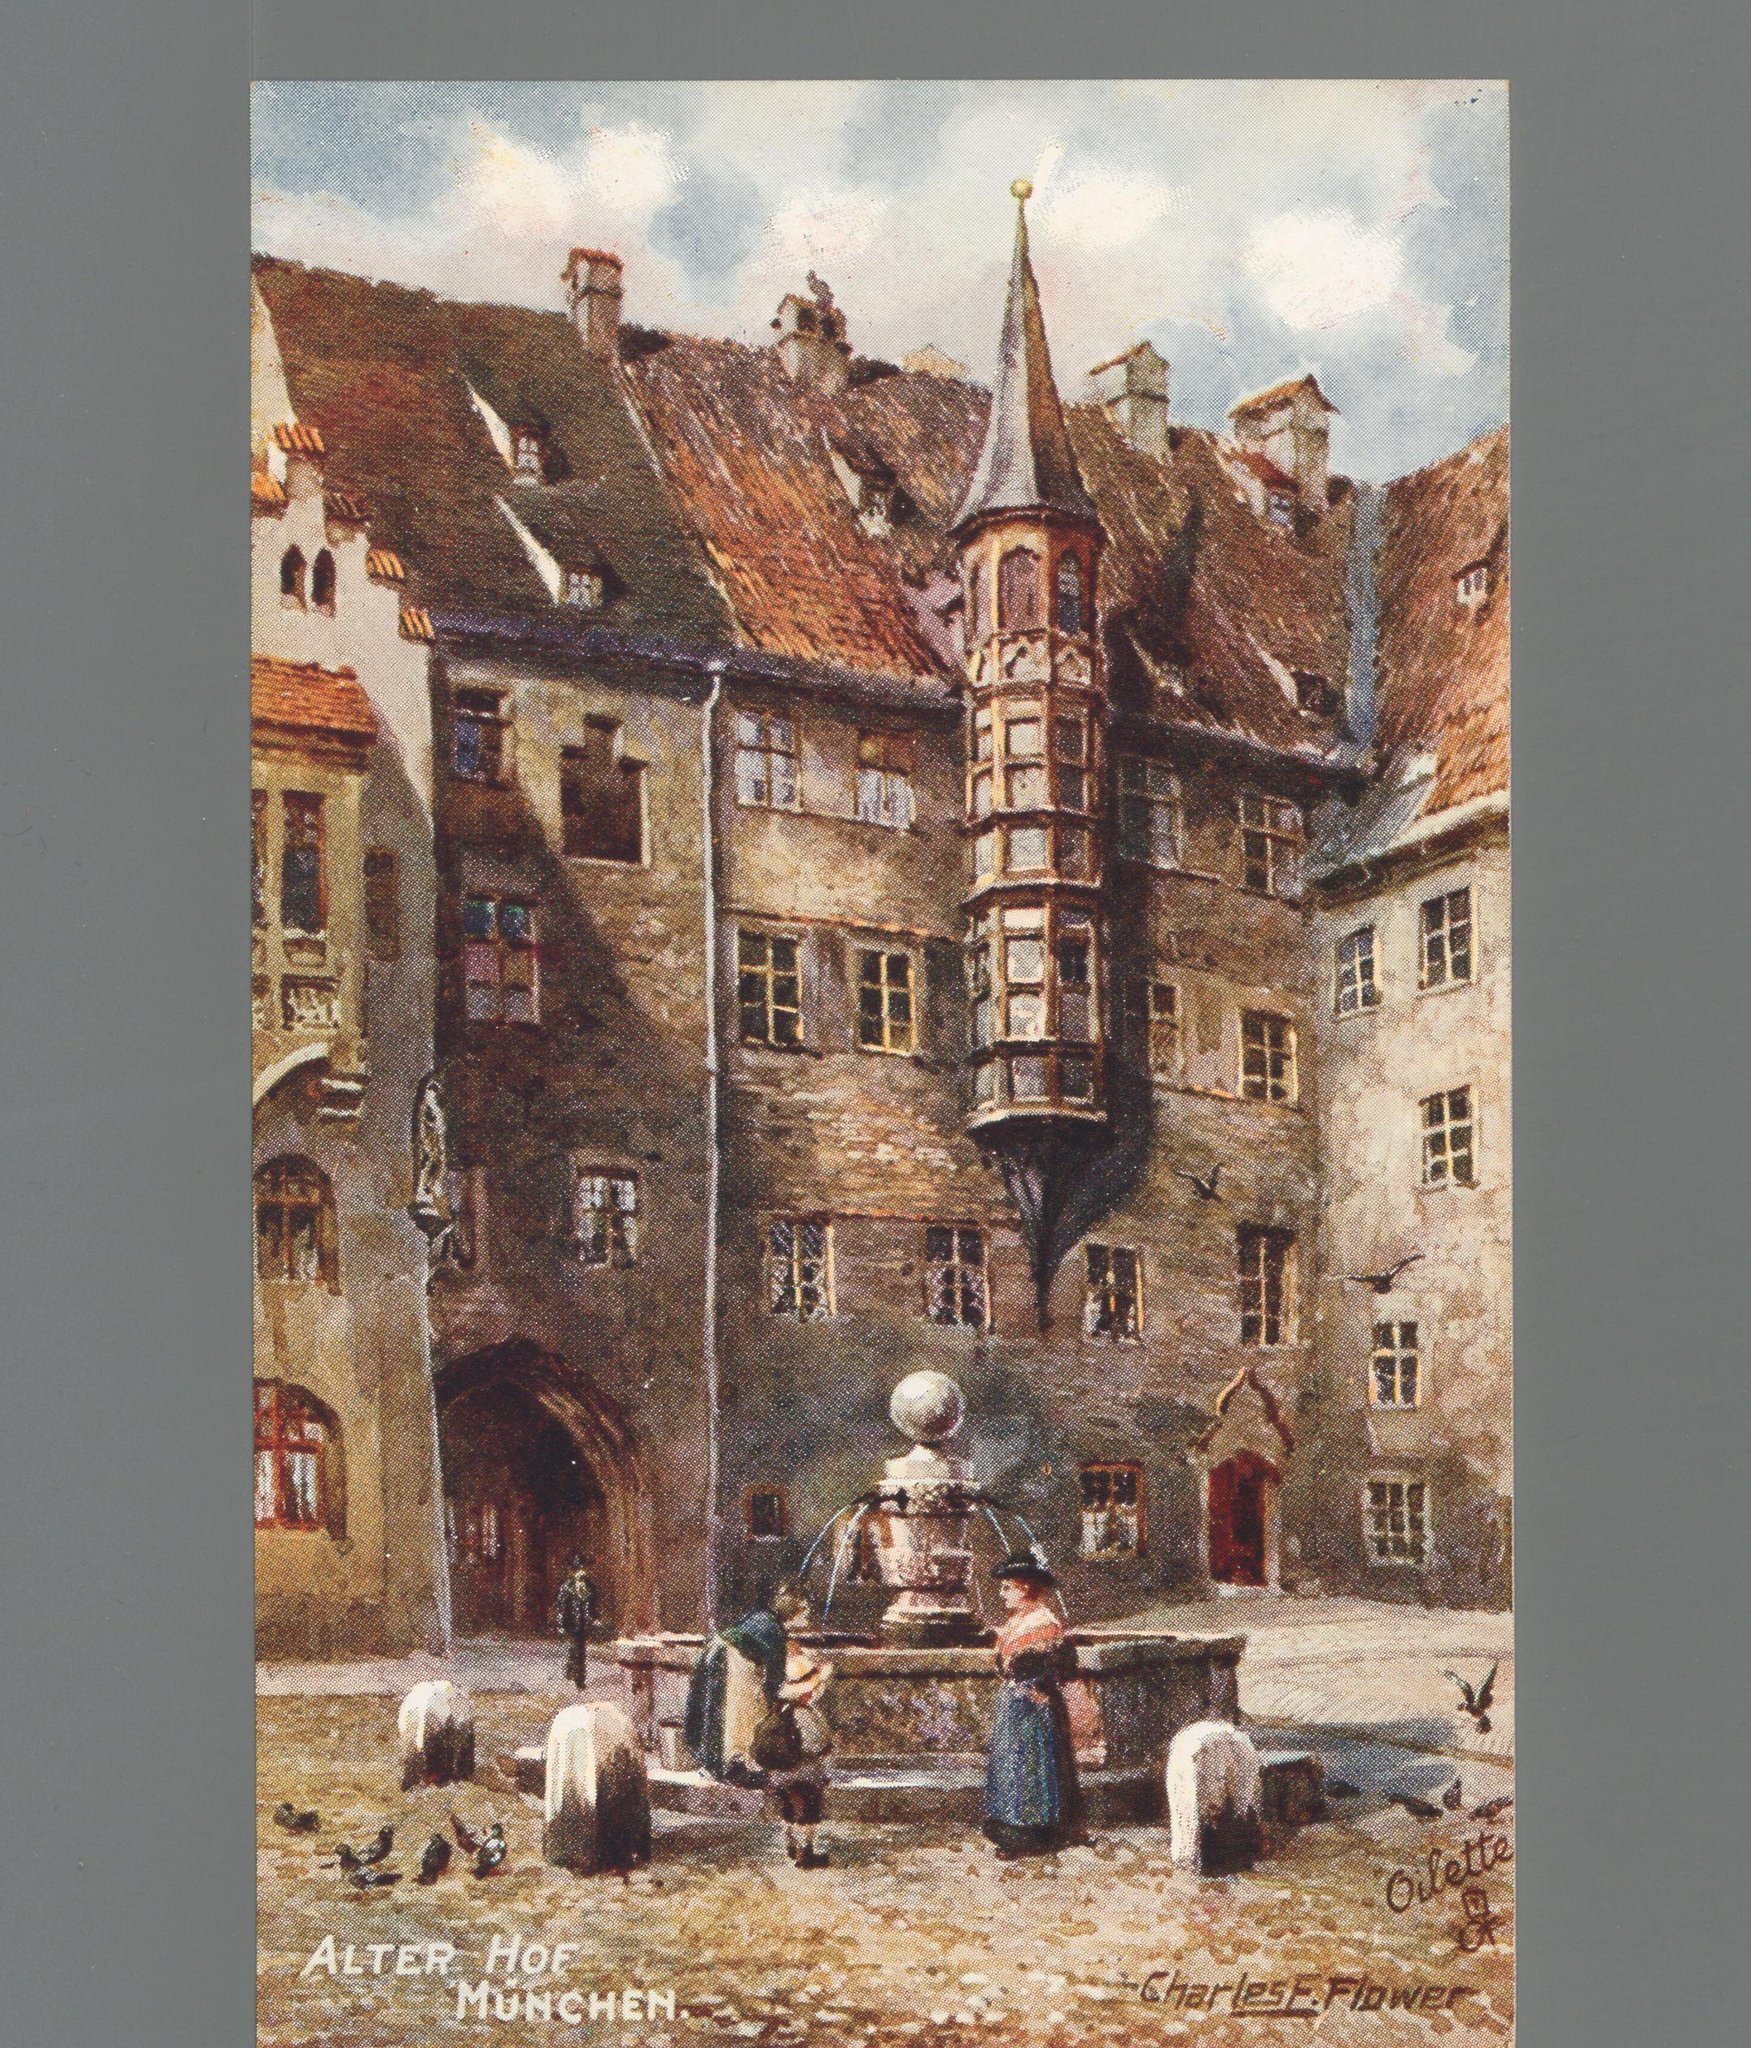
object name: reproduction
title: Alter Hof. München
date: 1907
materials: cardboard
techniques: writing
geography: london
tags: palace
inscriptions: inscription: ‘A.K.M.’